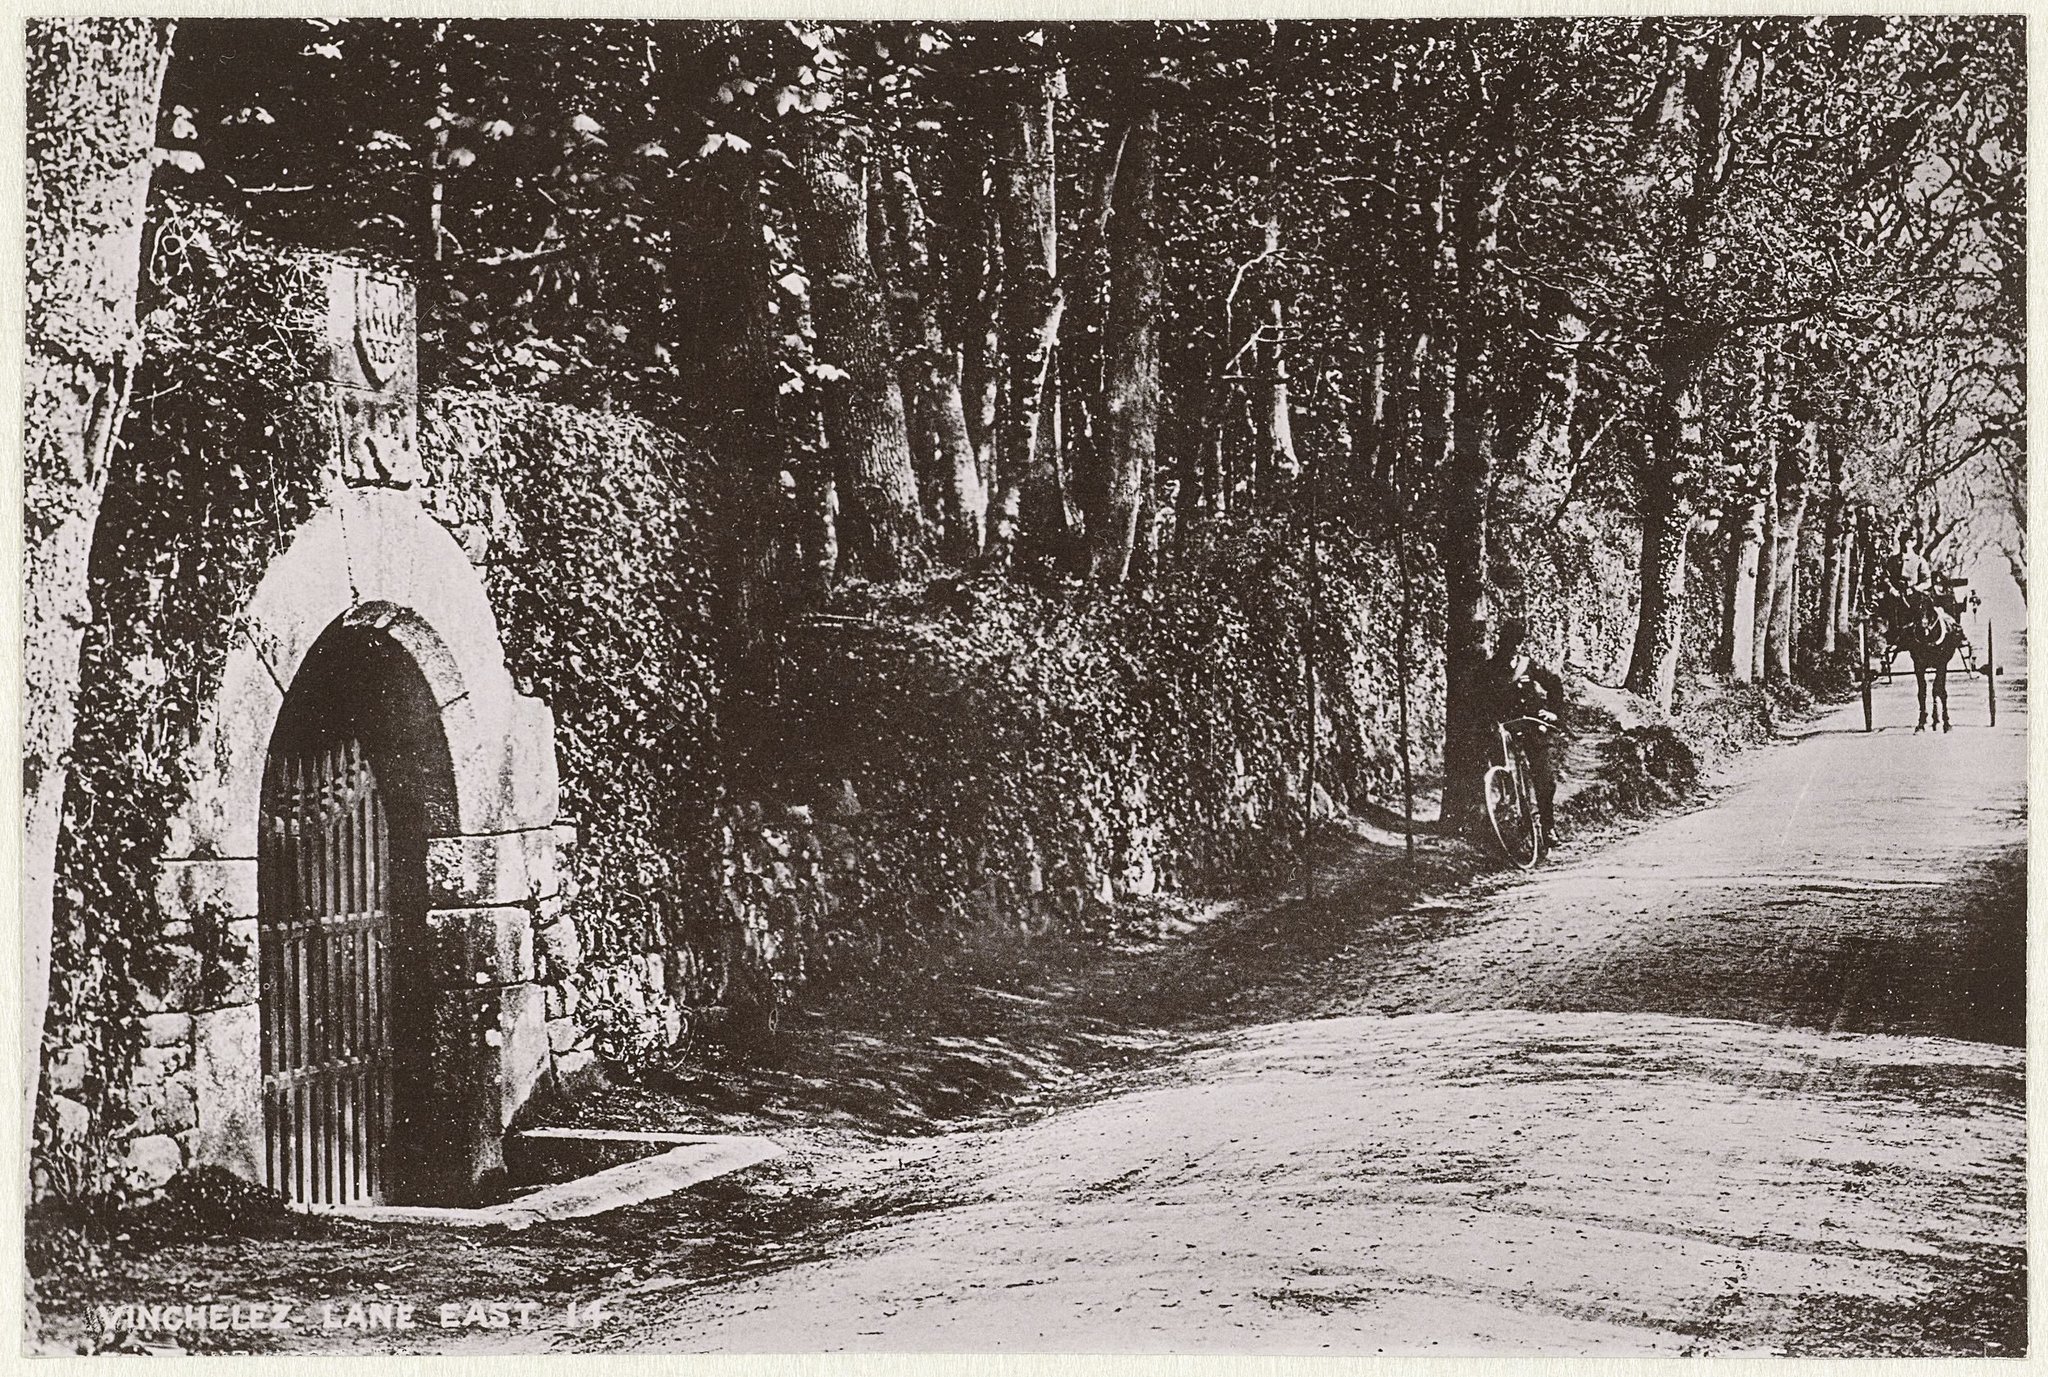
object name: photomechanical print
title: Vincheleze Lane East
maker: Anonymous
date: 1870-1930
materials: paper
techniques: photograph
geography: jersey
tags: forest path or lane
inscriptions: number: ‘14’